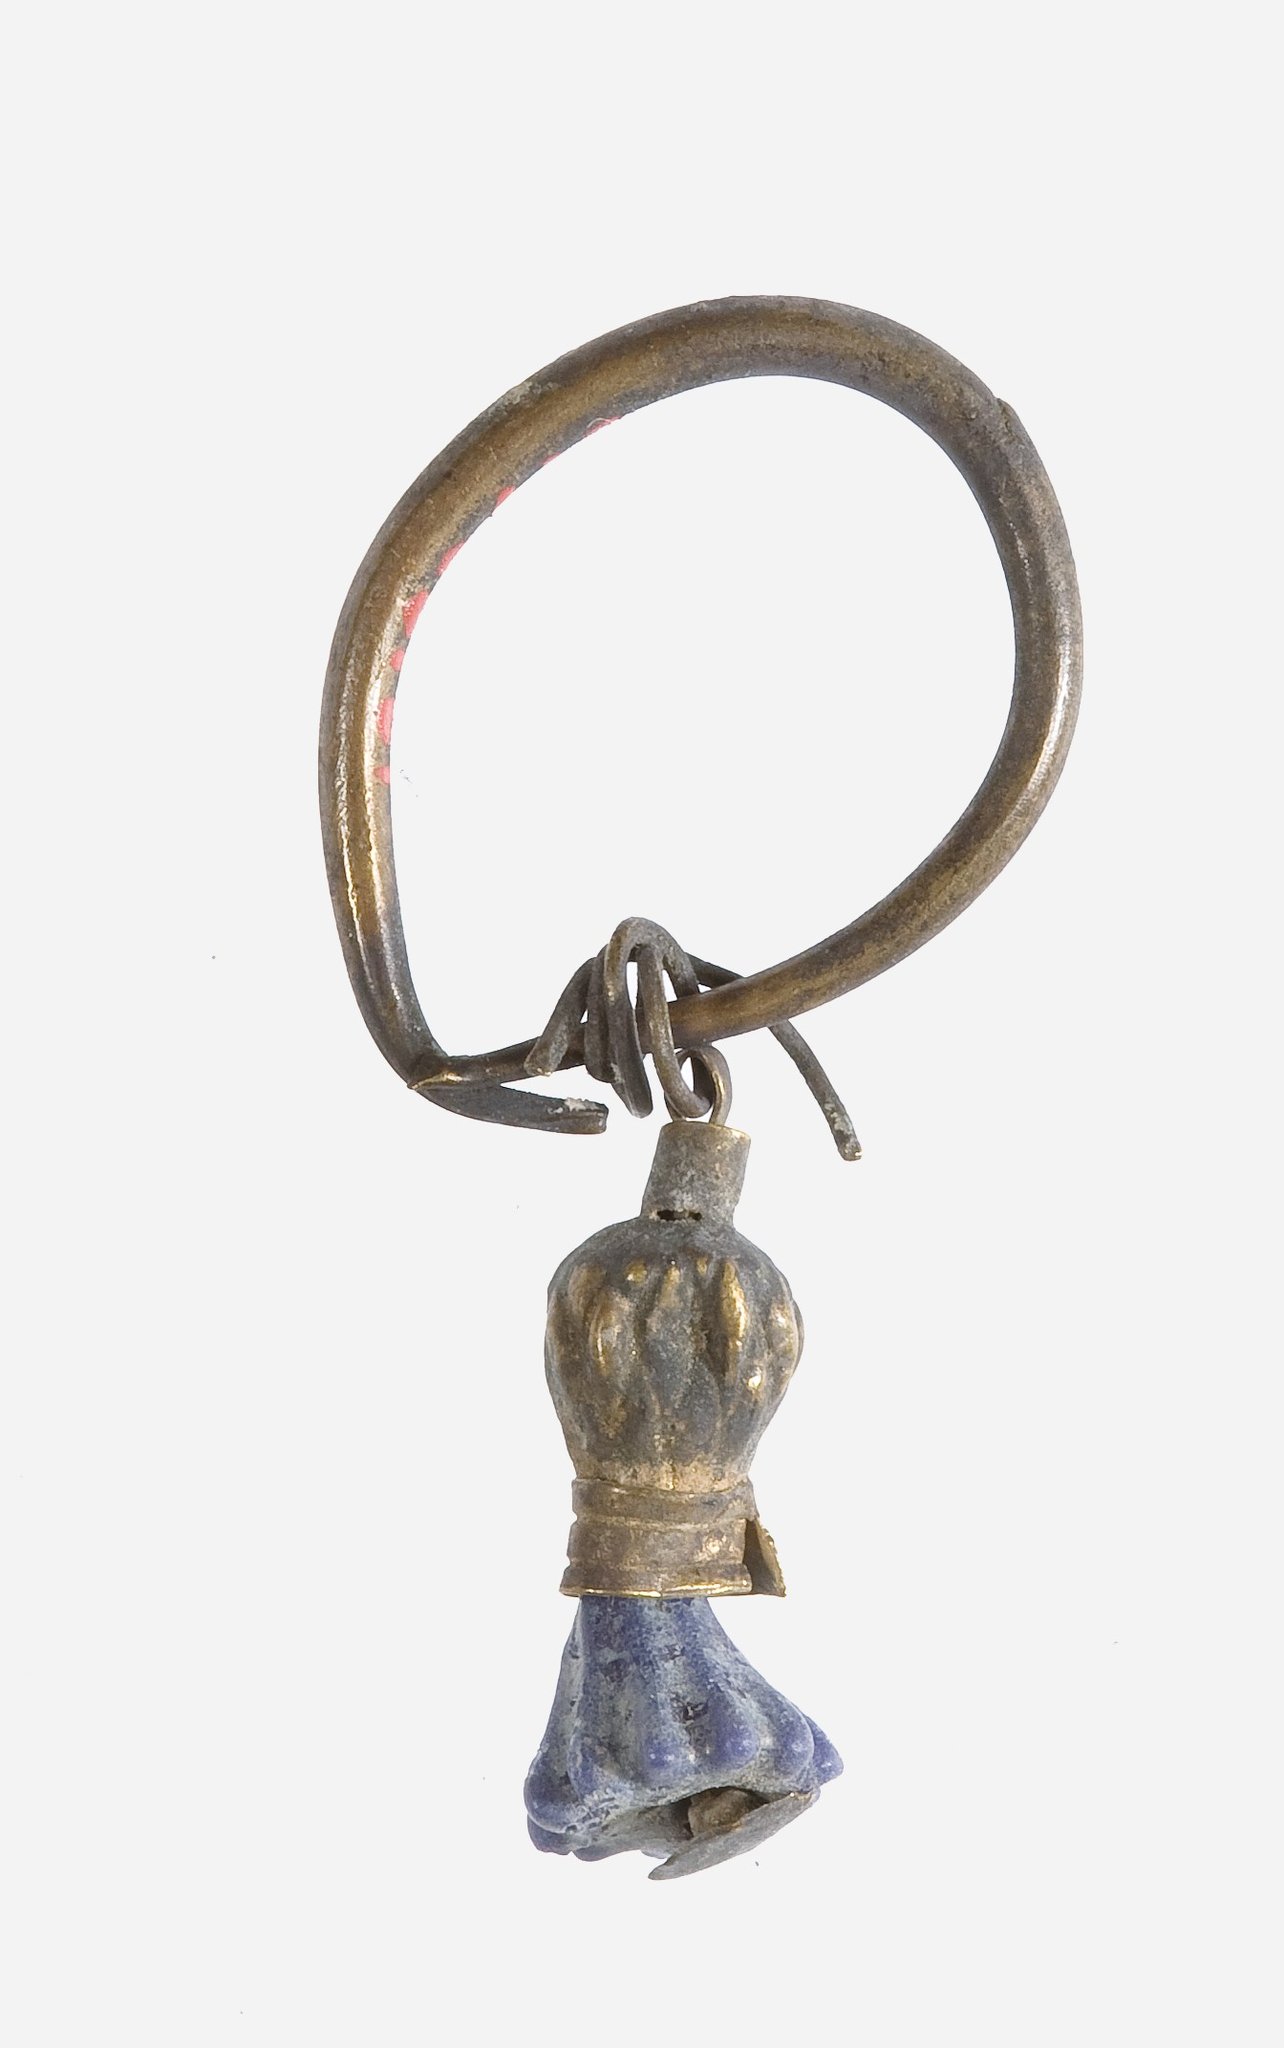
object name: earring, flower pendant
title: Earring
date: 1390-1352 BCE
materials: faience, gold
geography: egypt